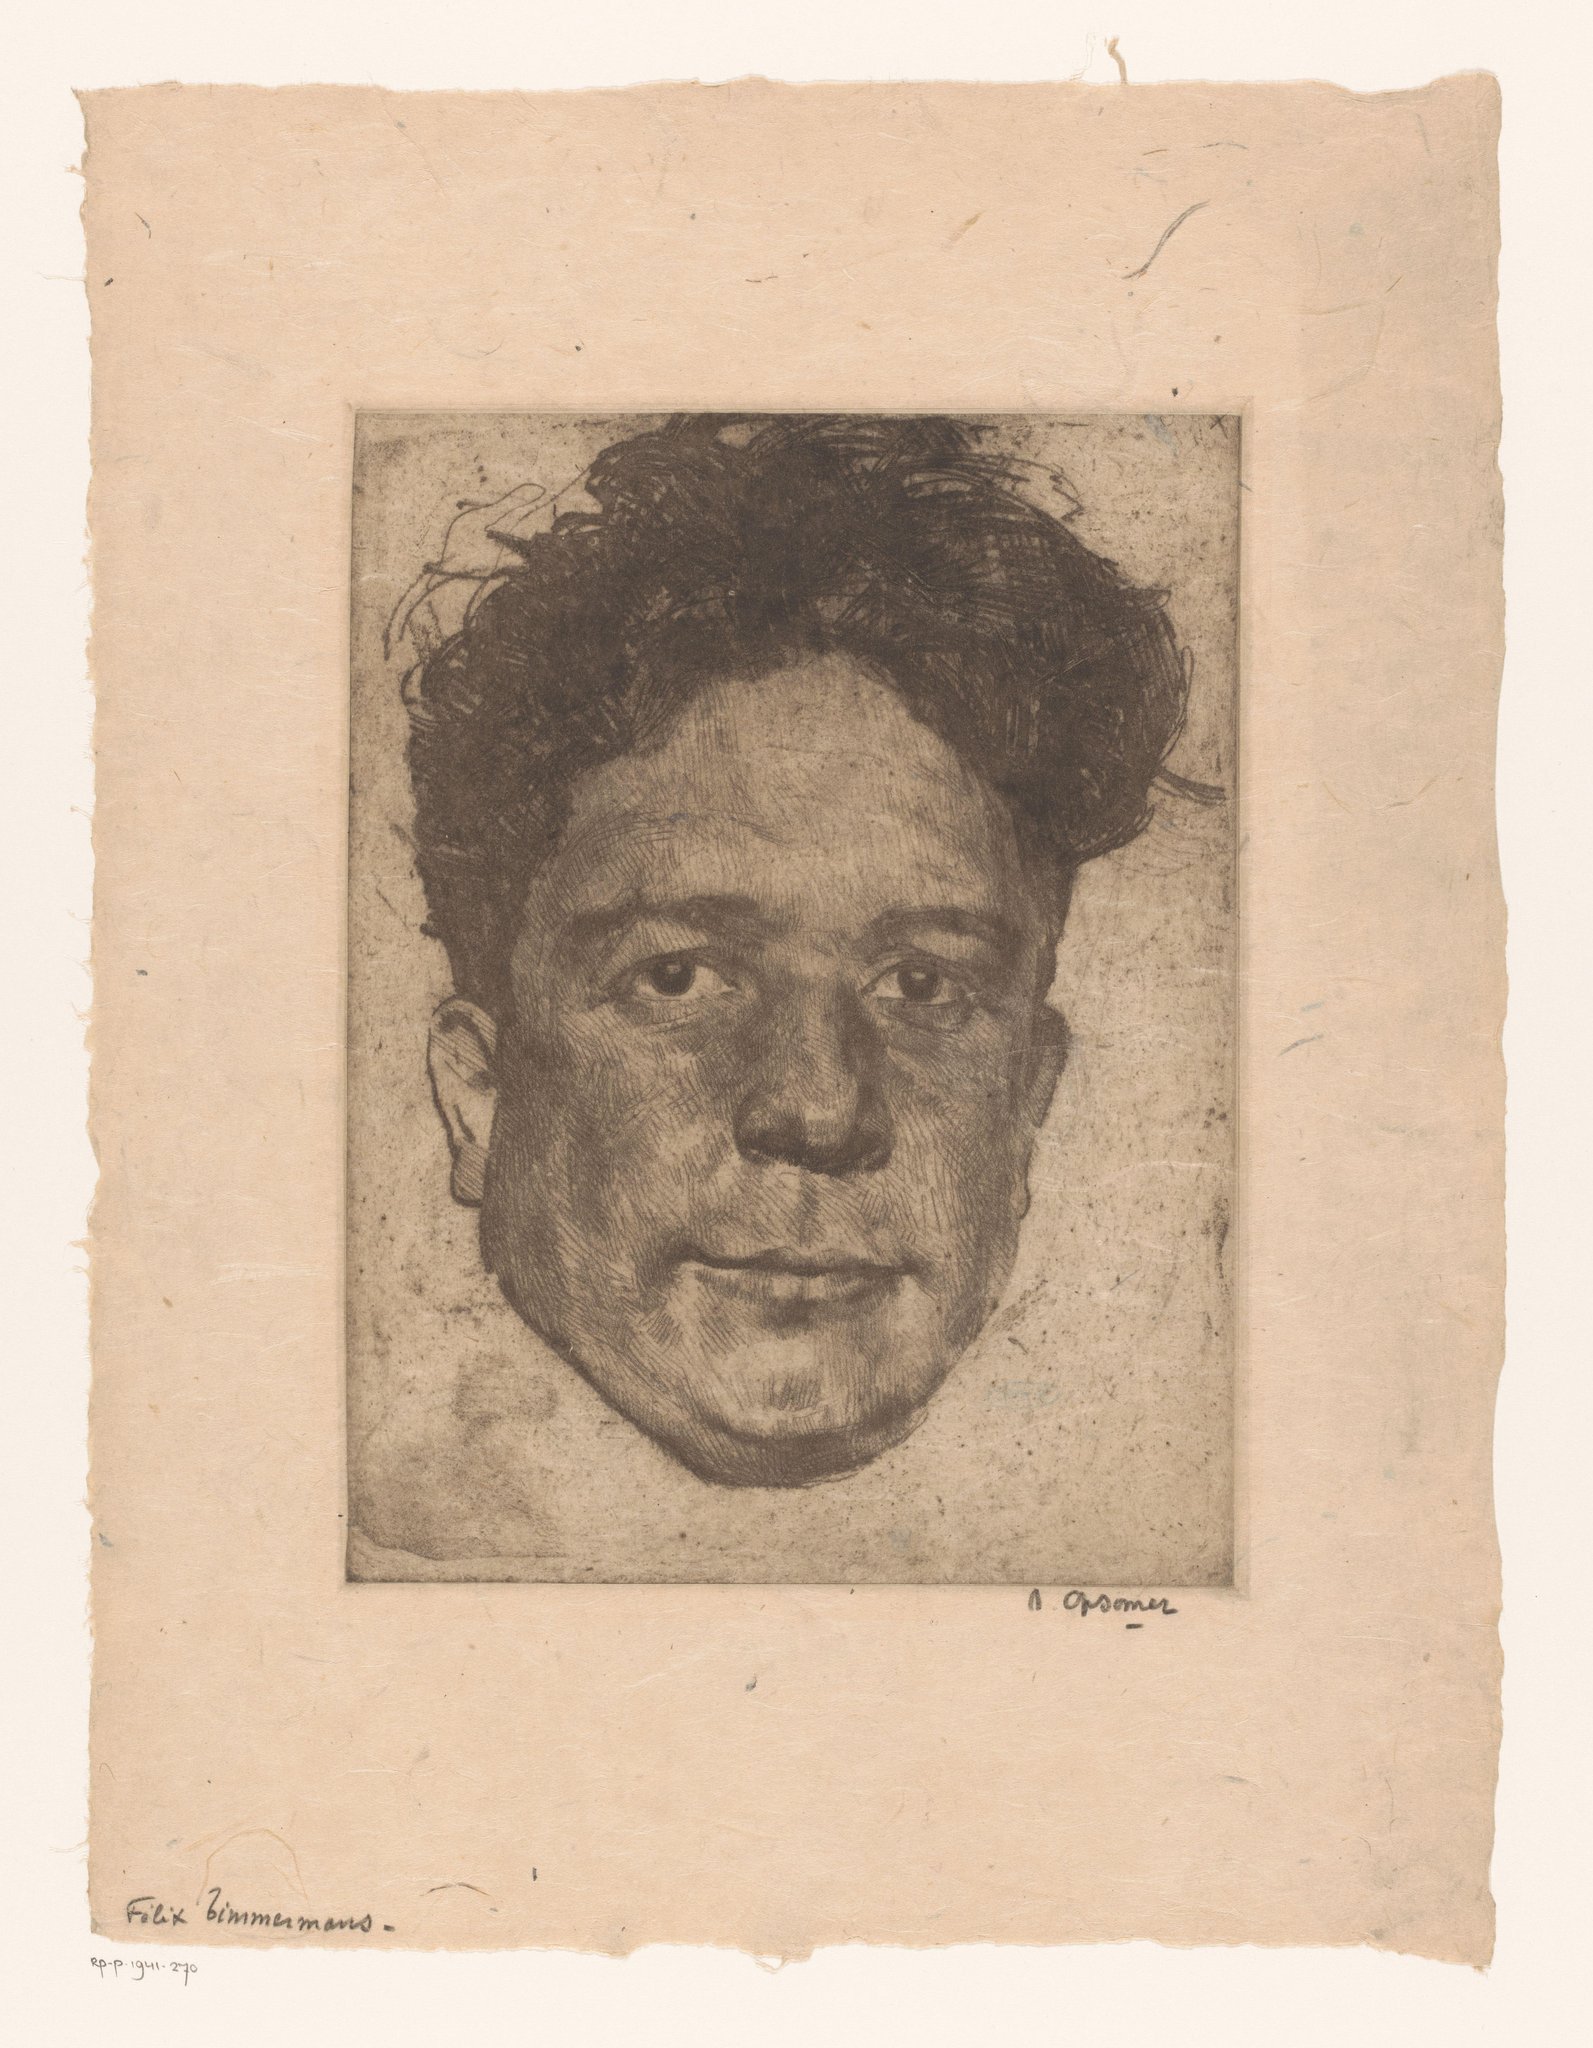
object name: print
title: Portret van Joan N. de Martini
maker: johann ernst mansfeld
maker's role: print maker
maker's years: 1739-1796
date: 1749-1796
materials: paper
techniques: engraving, etching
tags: historical persons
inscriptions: collector's mark: Lugt 2228